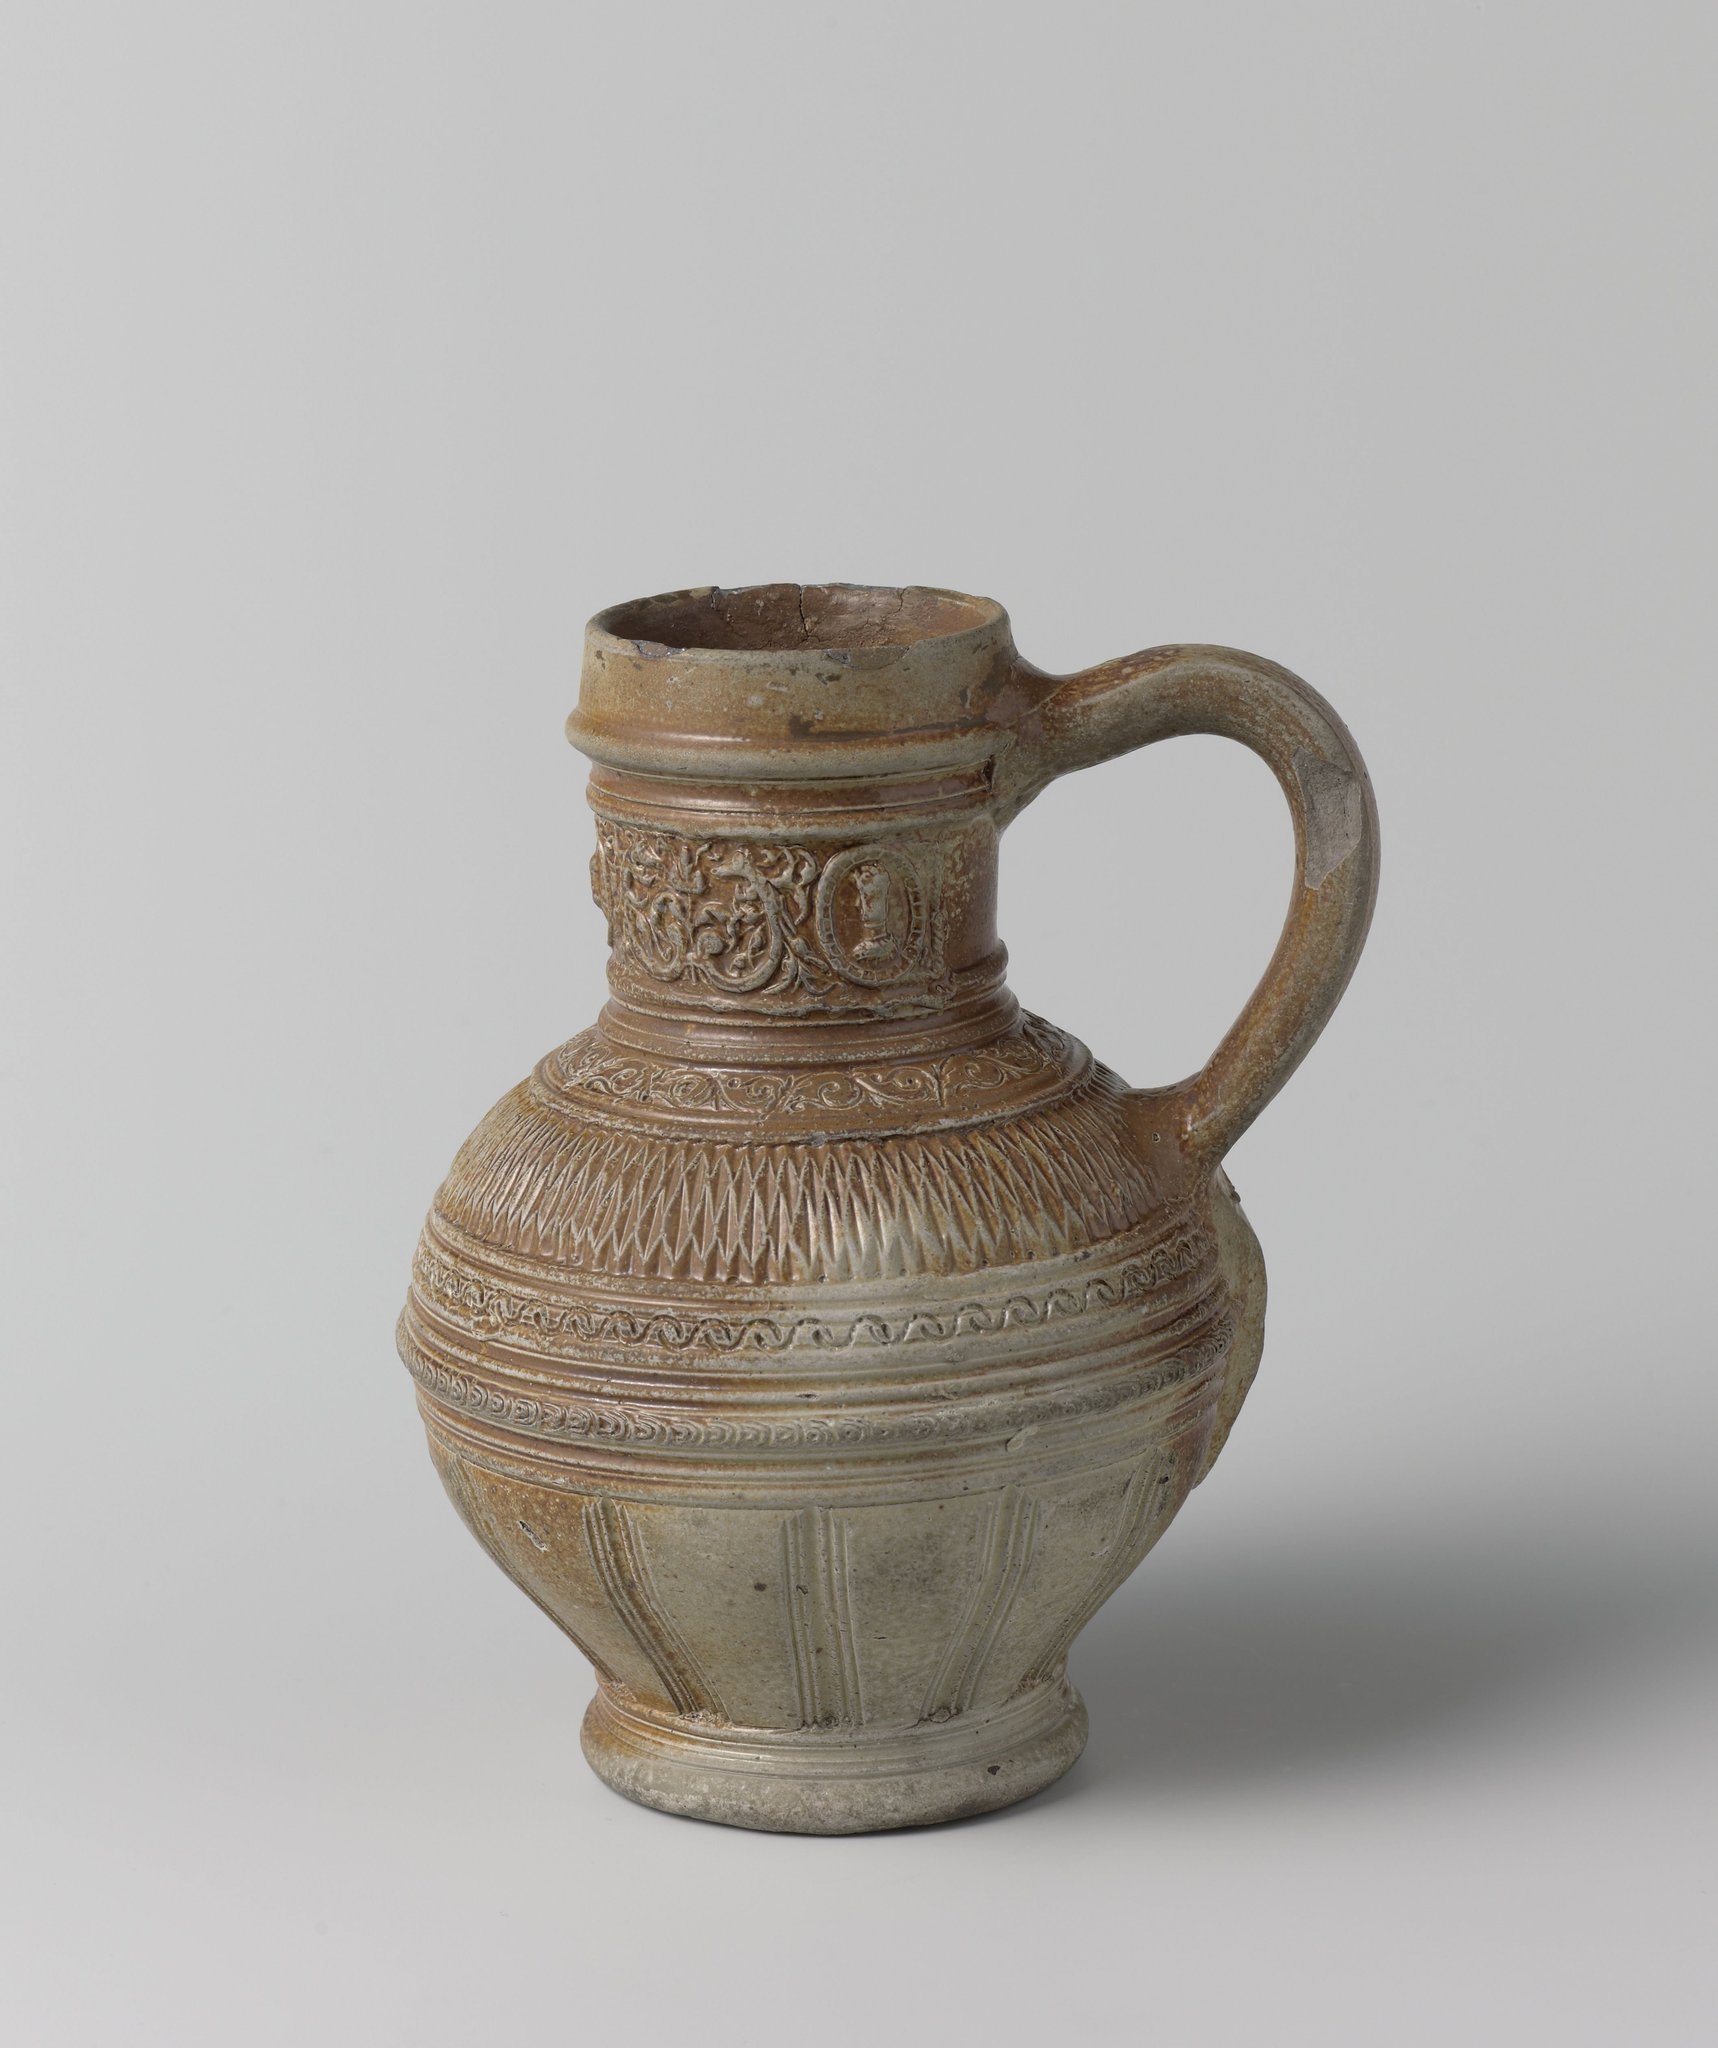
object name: jug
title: Jug with medallions, foliate scrolls and chip carving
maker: Anonymous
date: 1550-1599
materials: engobe, glaze, stoneware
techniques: firing, forming, relief, turning, vitrification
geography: raeren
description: Kruik van steengoed op standring met een bolvormig lichaam en wijde nek. Het C-vormige oor is bevestigd aan de nek en de schouder. Profielen op de nek, buik en voet. Bedekt met een bruine engobe. Het onderste deel van de buik is verdeeld in vakken. Op de schouder ingegrifte decoratieve banden en een bredere band met kerfsnede. De nek met in reliëf een gedrukte en opgelegde band met portretten of maskers in medaillons, onderbroken door bladranken. Raeren.